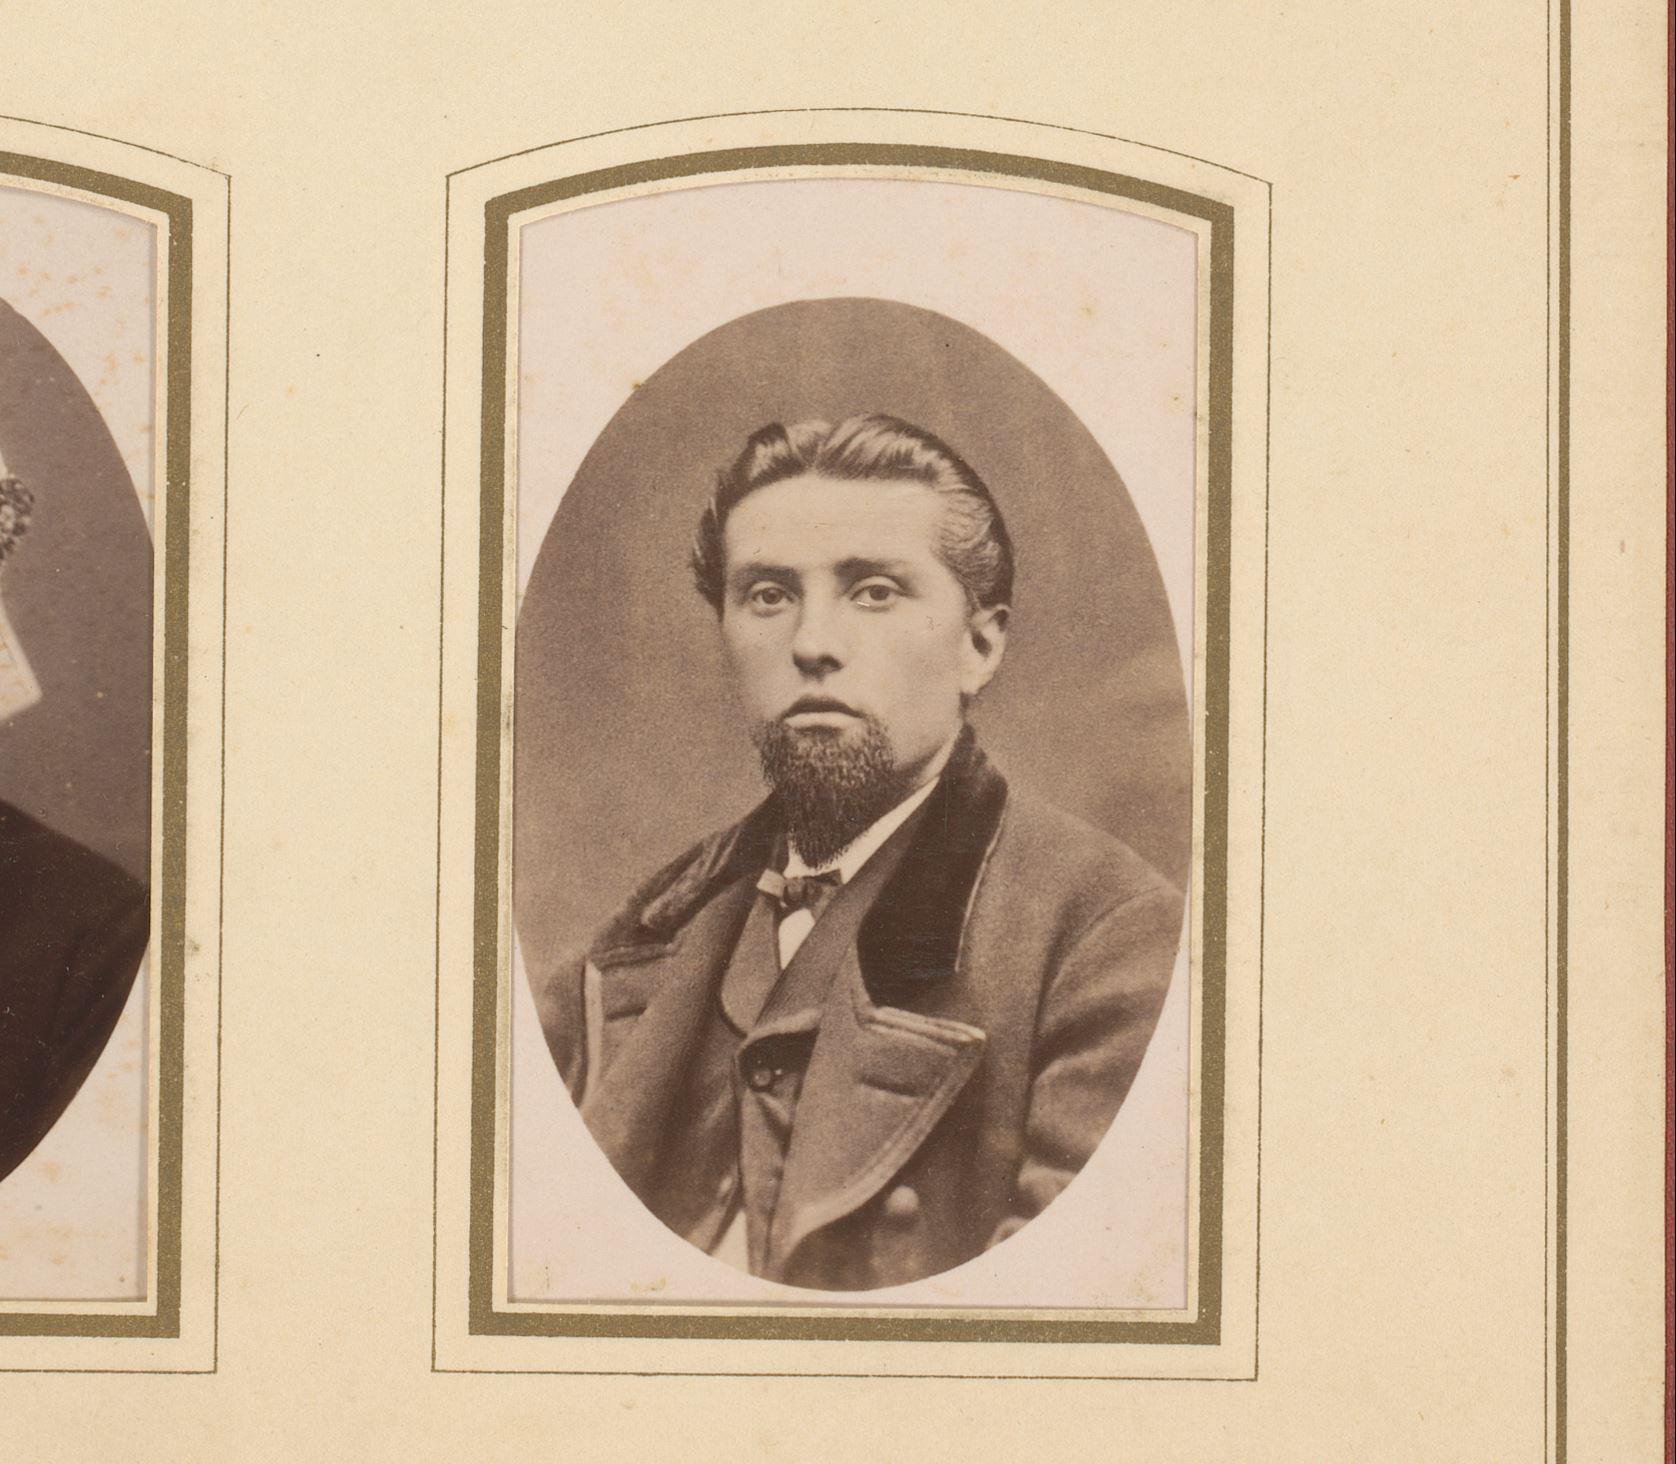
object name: album leaf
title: Portret van een man met snor en sik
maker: Anonymous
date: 1860-1900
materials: cardboard, photographic support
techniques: albumen print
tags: historical persons, beard